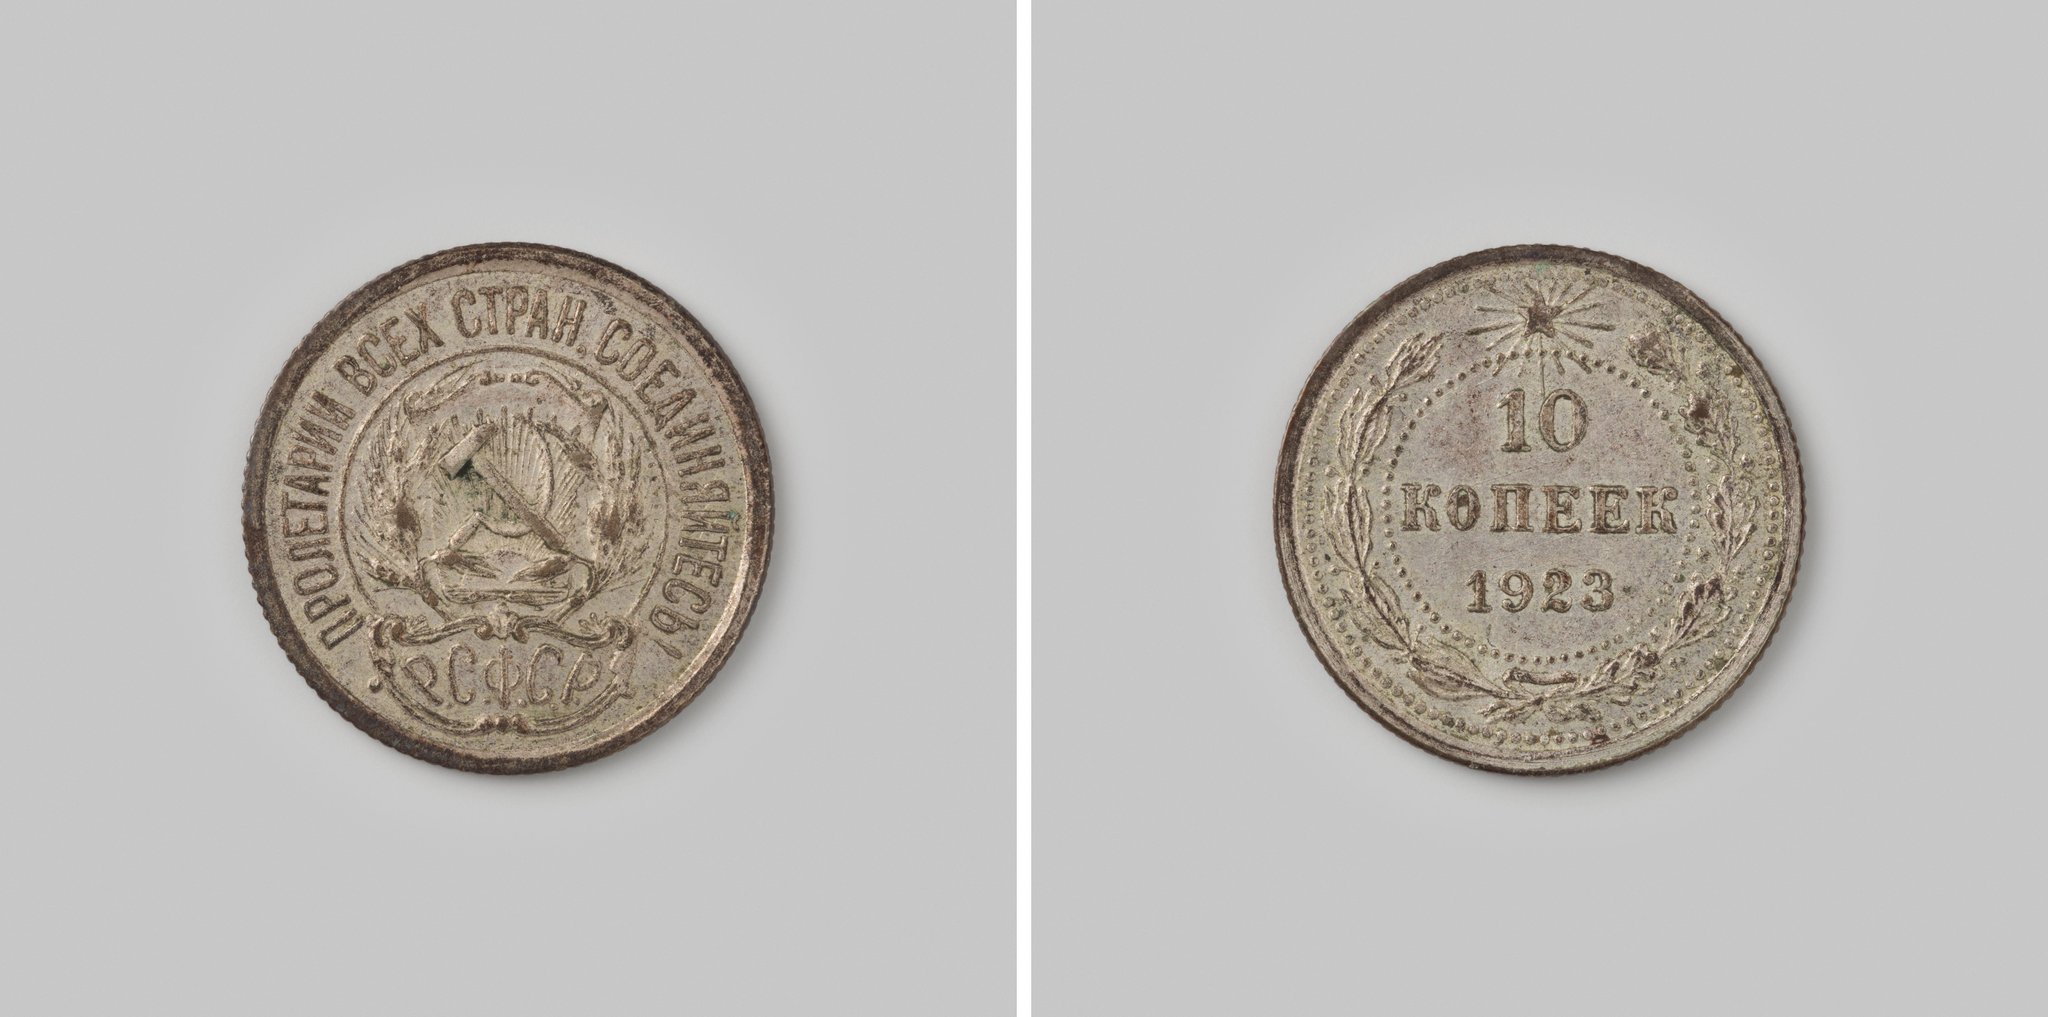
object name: coin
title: 10 kopeken uit Rusland, 1923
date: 1923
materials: silver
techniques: striking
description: Zilveren munt. Voorzijde: wapen van de R.S.F.S.R., waaronder in een cartouche landsaanduiding in Cyrillische letters R,S, F,S en R. Keerzijde: tussen twee samengebonden takken waarde-aanduiding in twee regels, waaronder jaartal. Bovenaan stralende zon. Kartelrand.